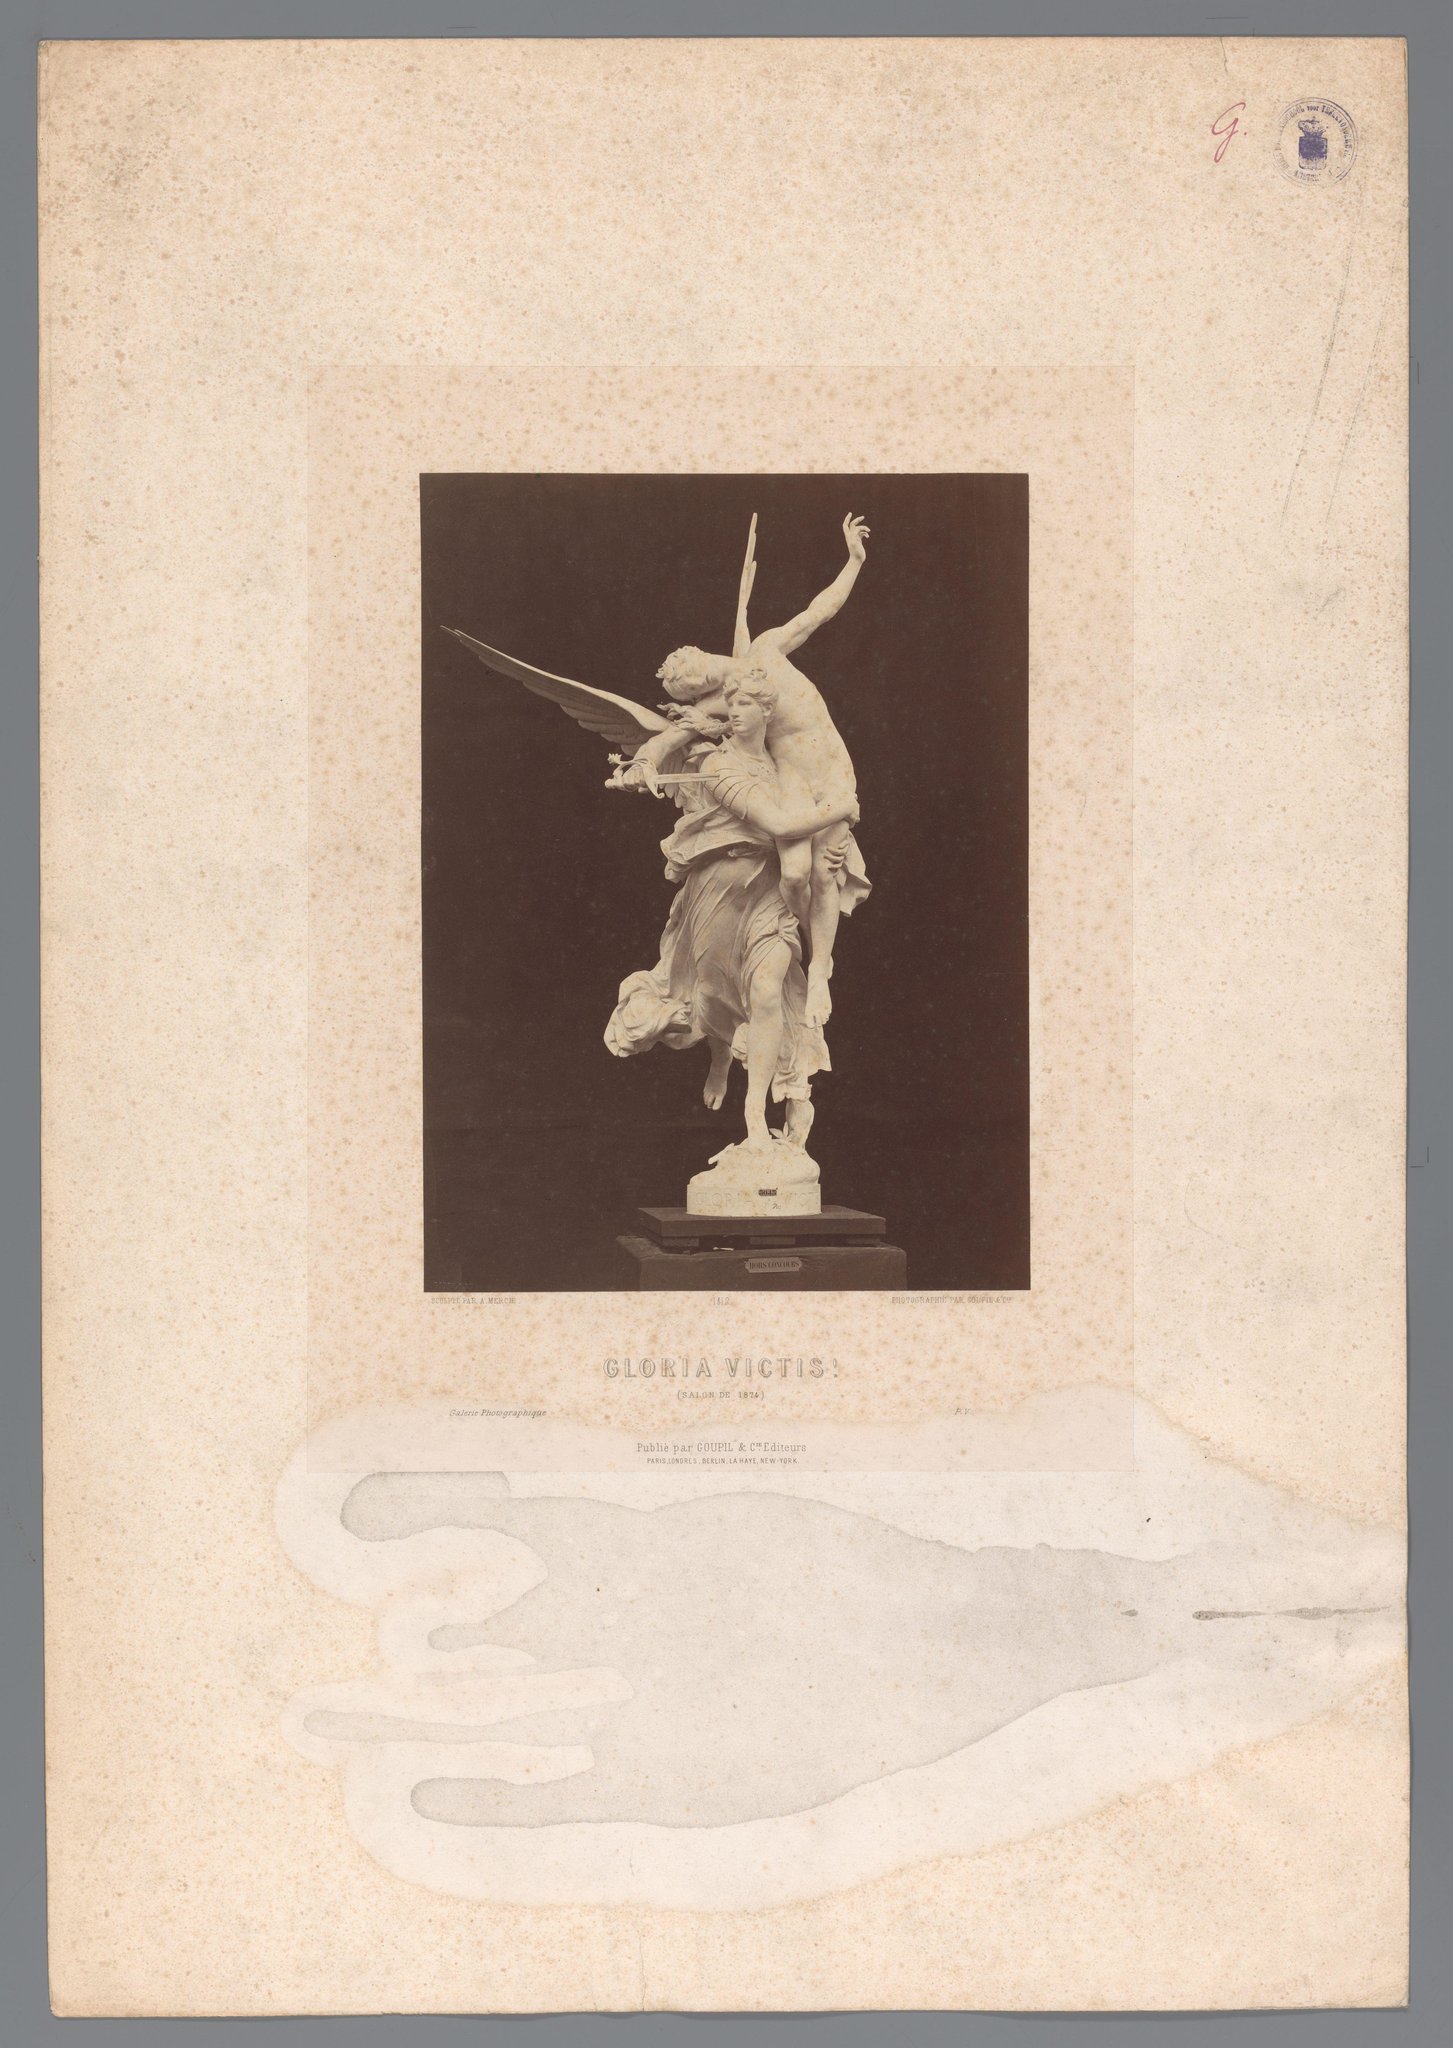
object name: photograph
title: Gloria Victis (Salon de 1874)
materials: cardboard, paper, photographic support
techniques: albumen print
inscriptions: stamp, : ‘G’